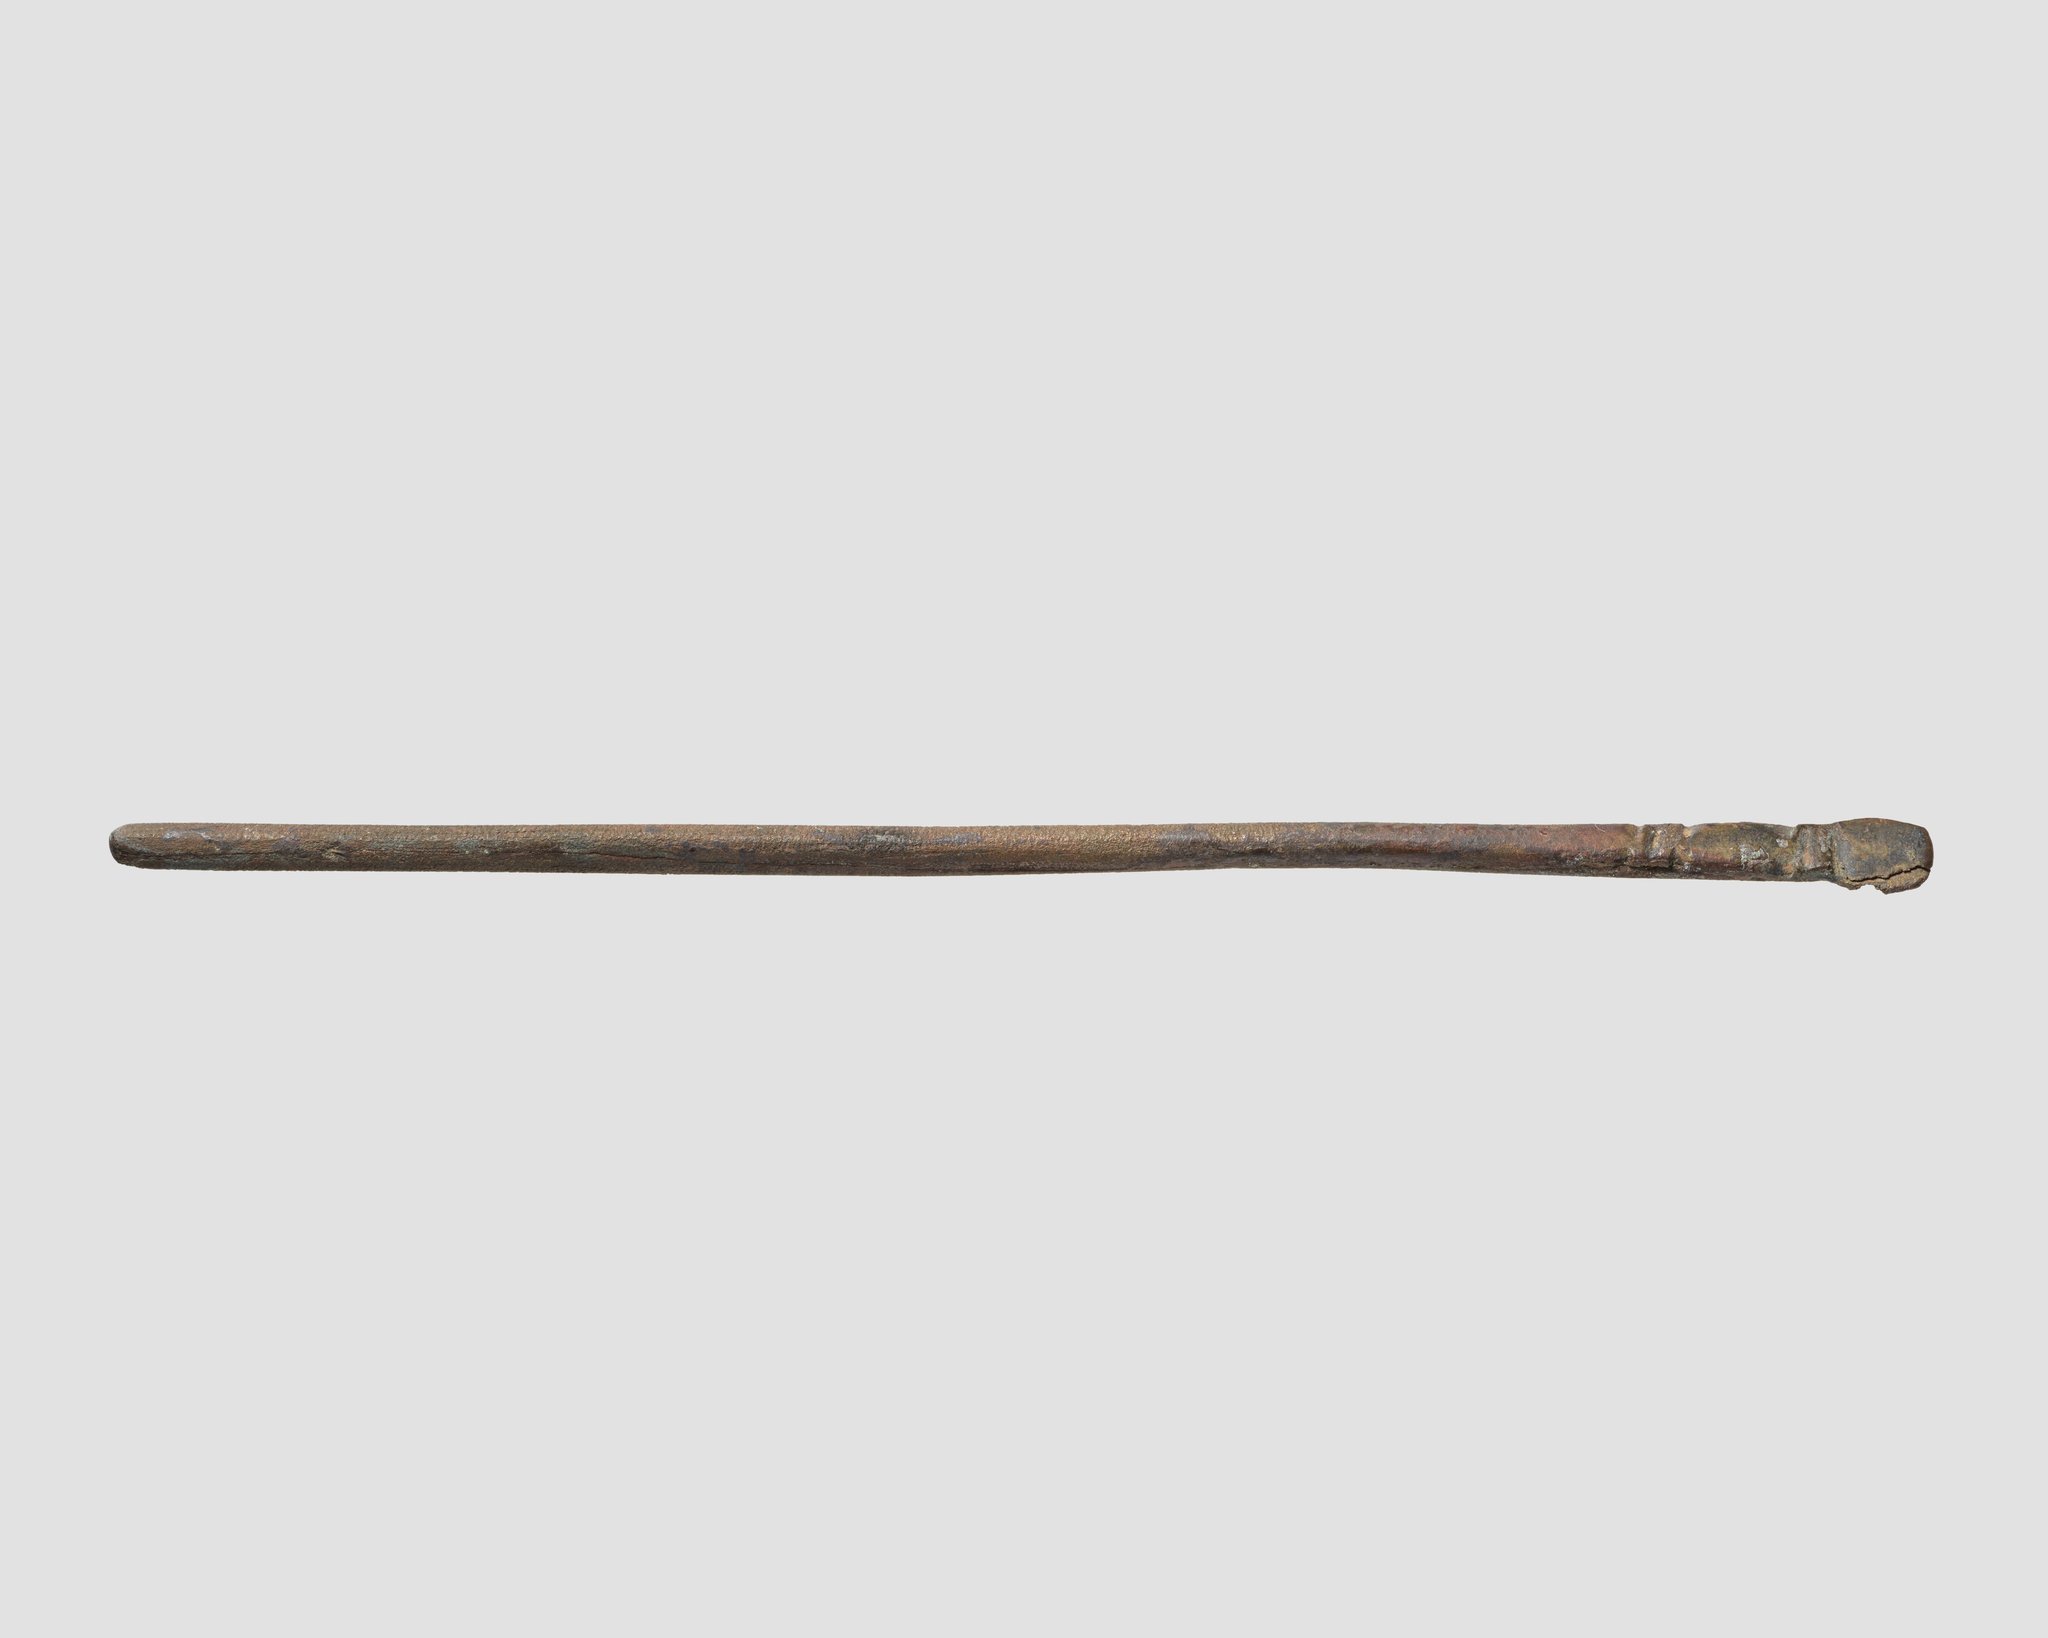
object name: spatula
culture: islamic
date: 801-1000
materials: bronze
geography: iran